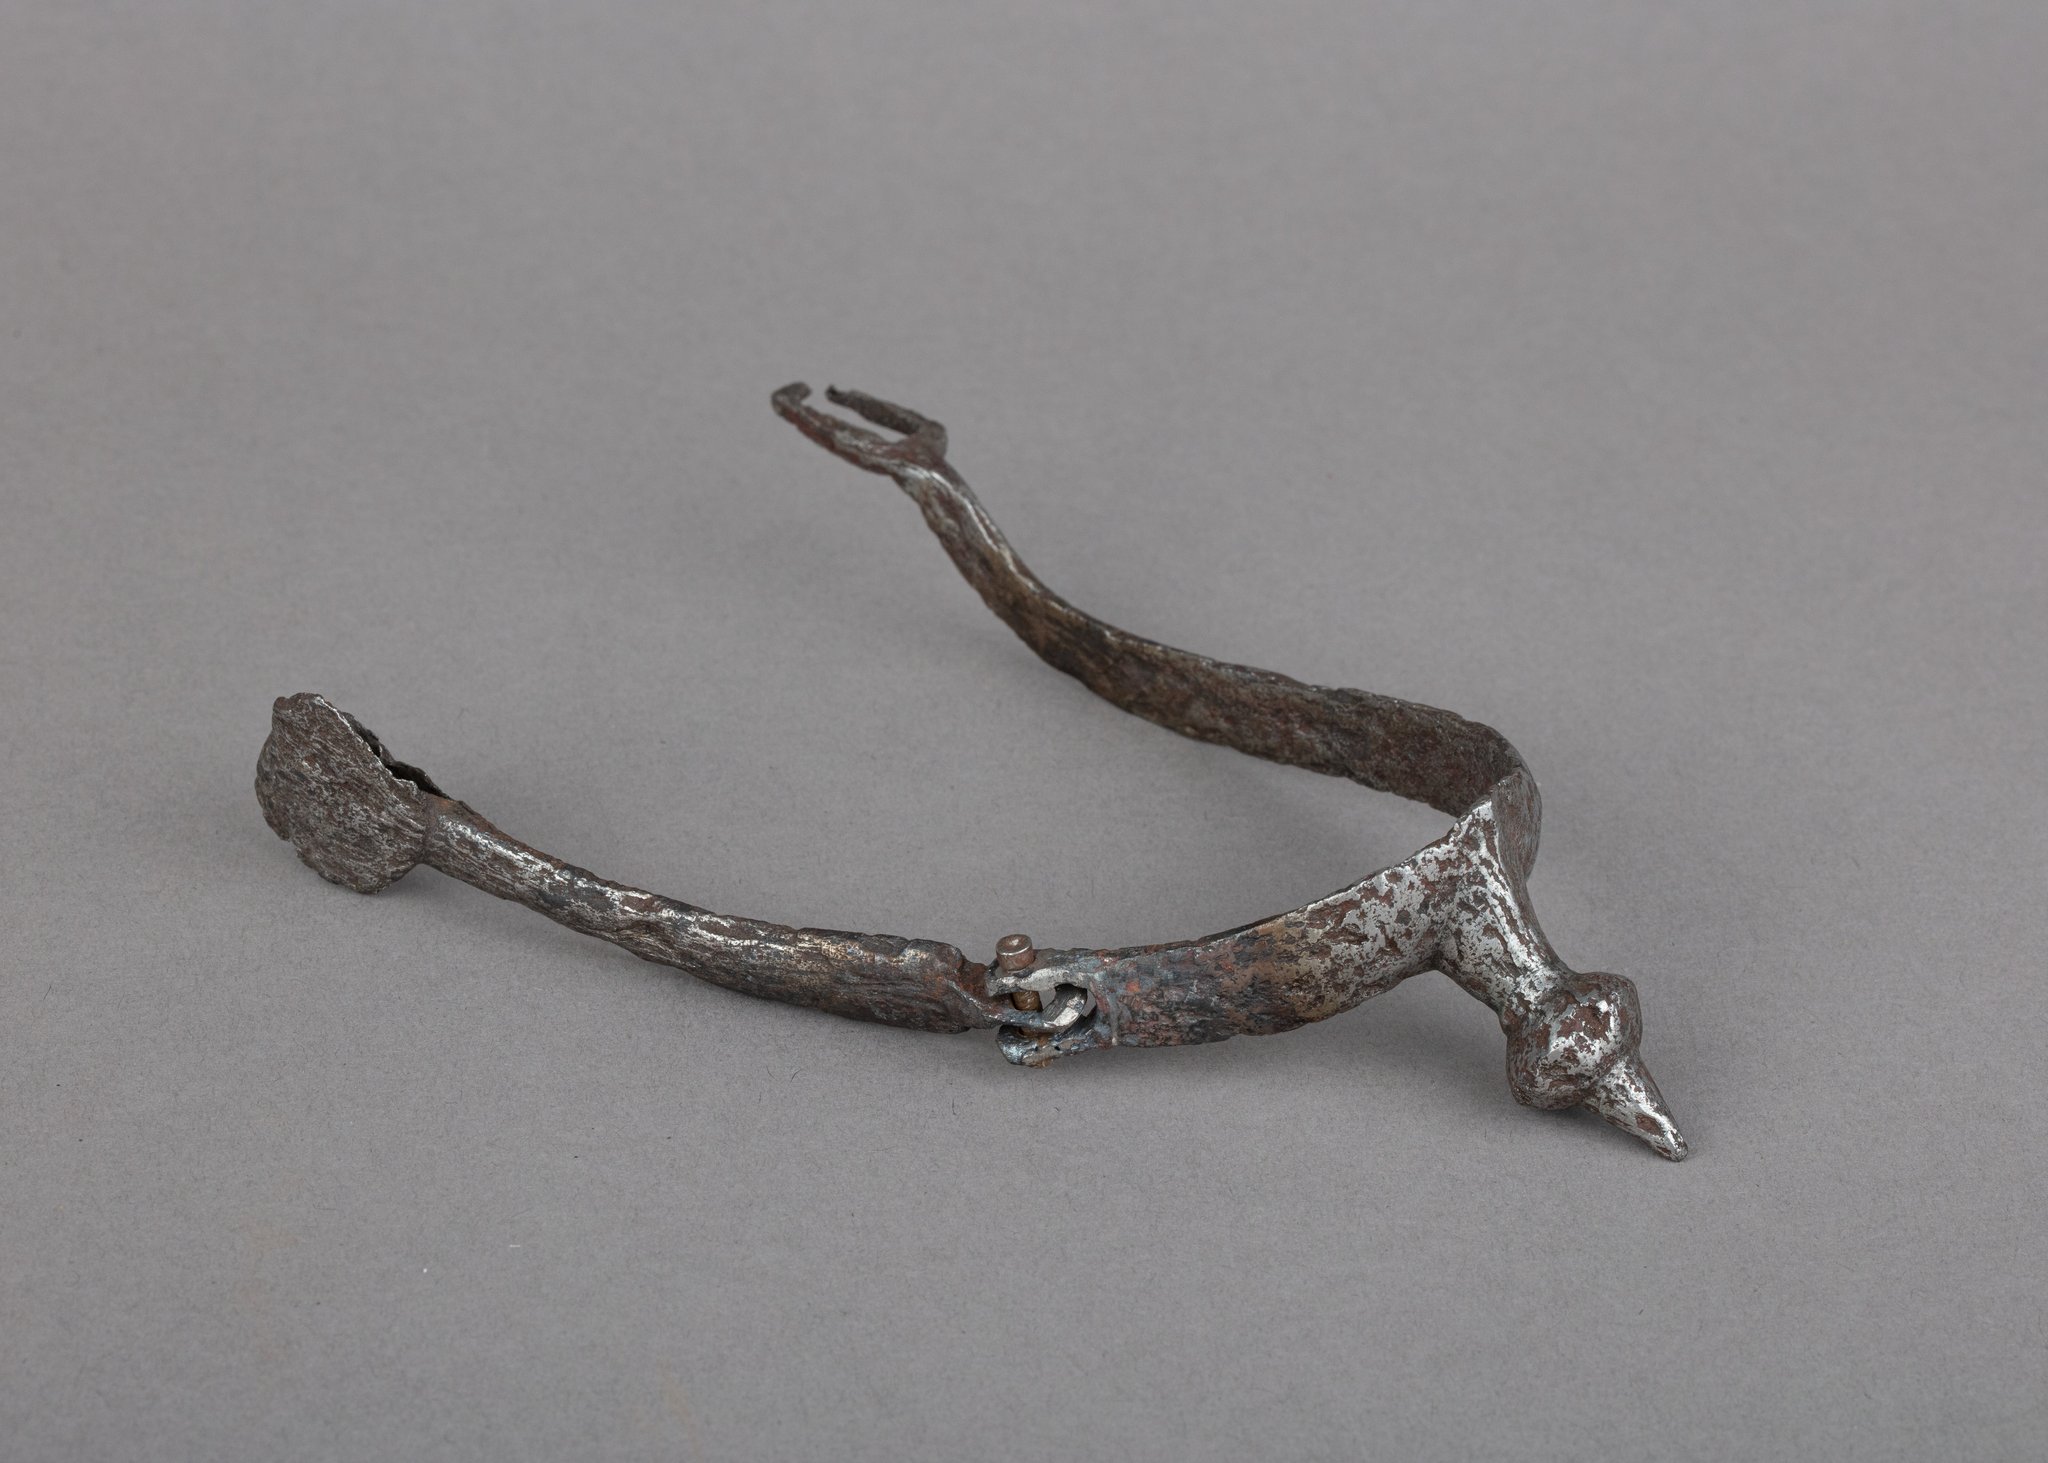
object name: spur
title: Prick Spur (Left)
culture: german or slavic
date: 1201-1300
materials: metal alloy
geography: poland